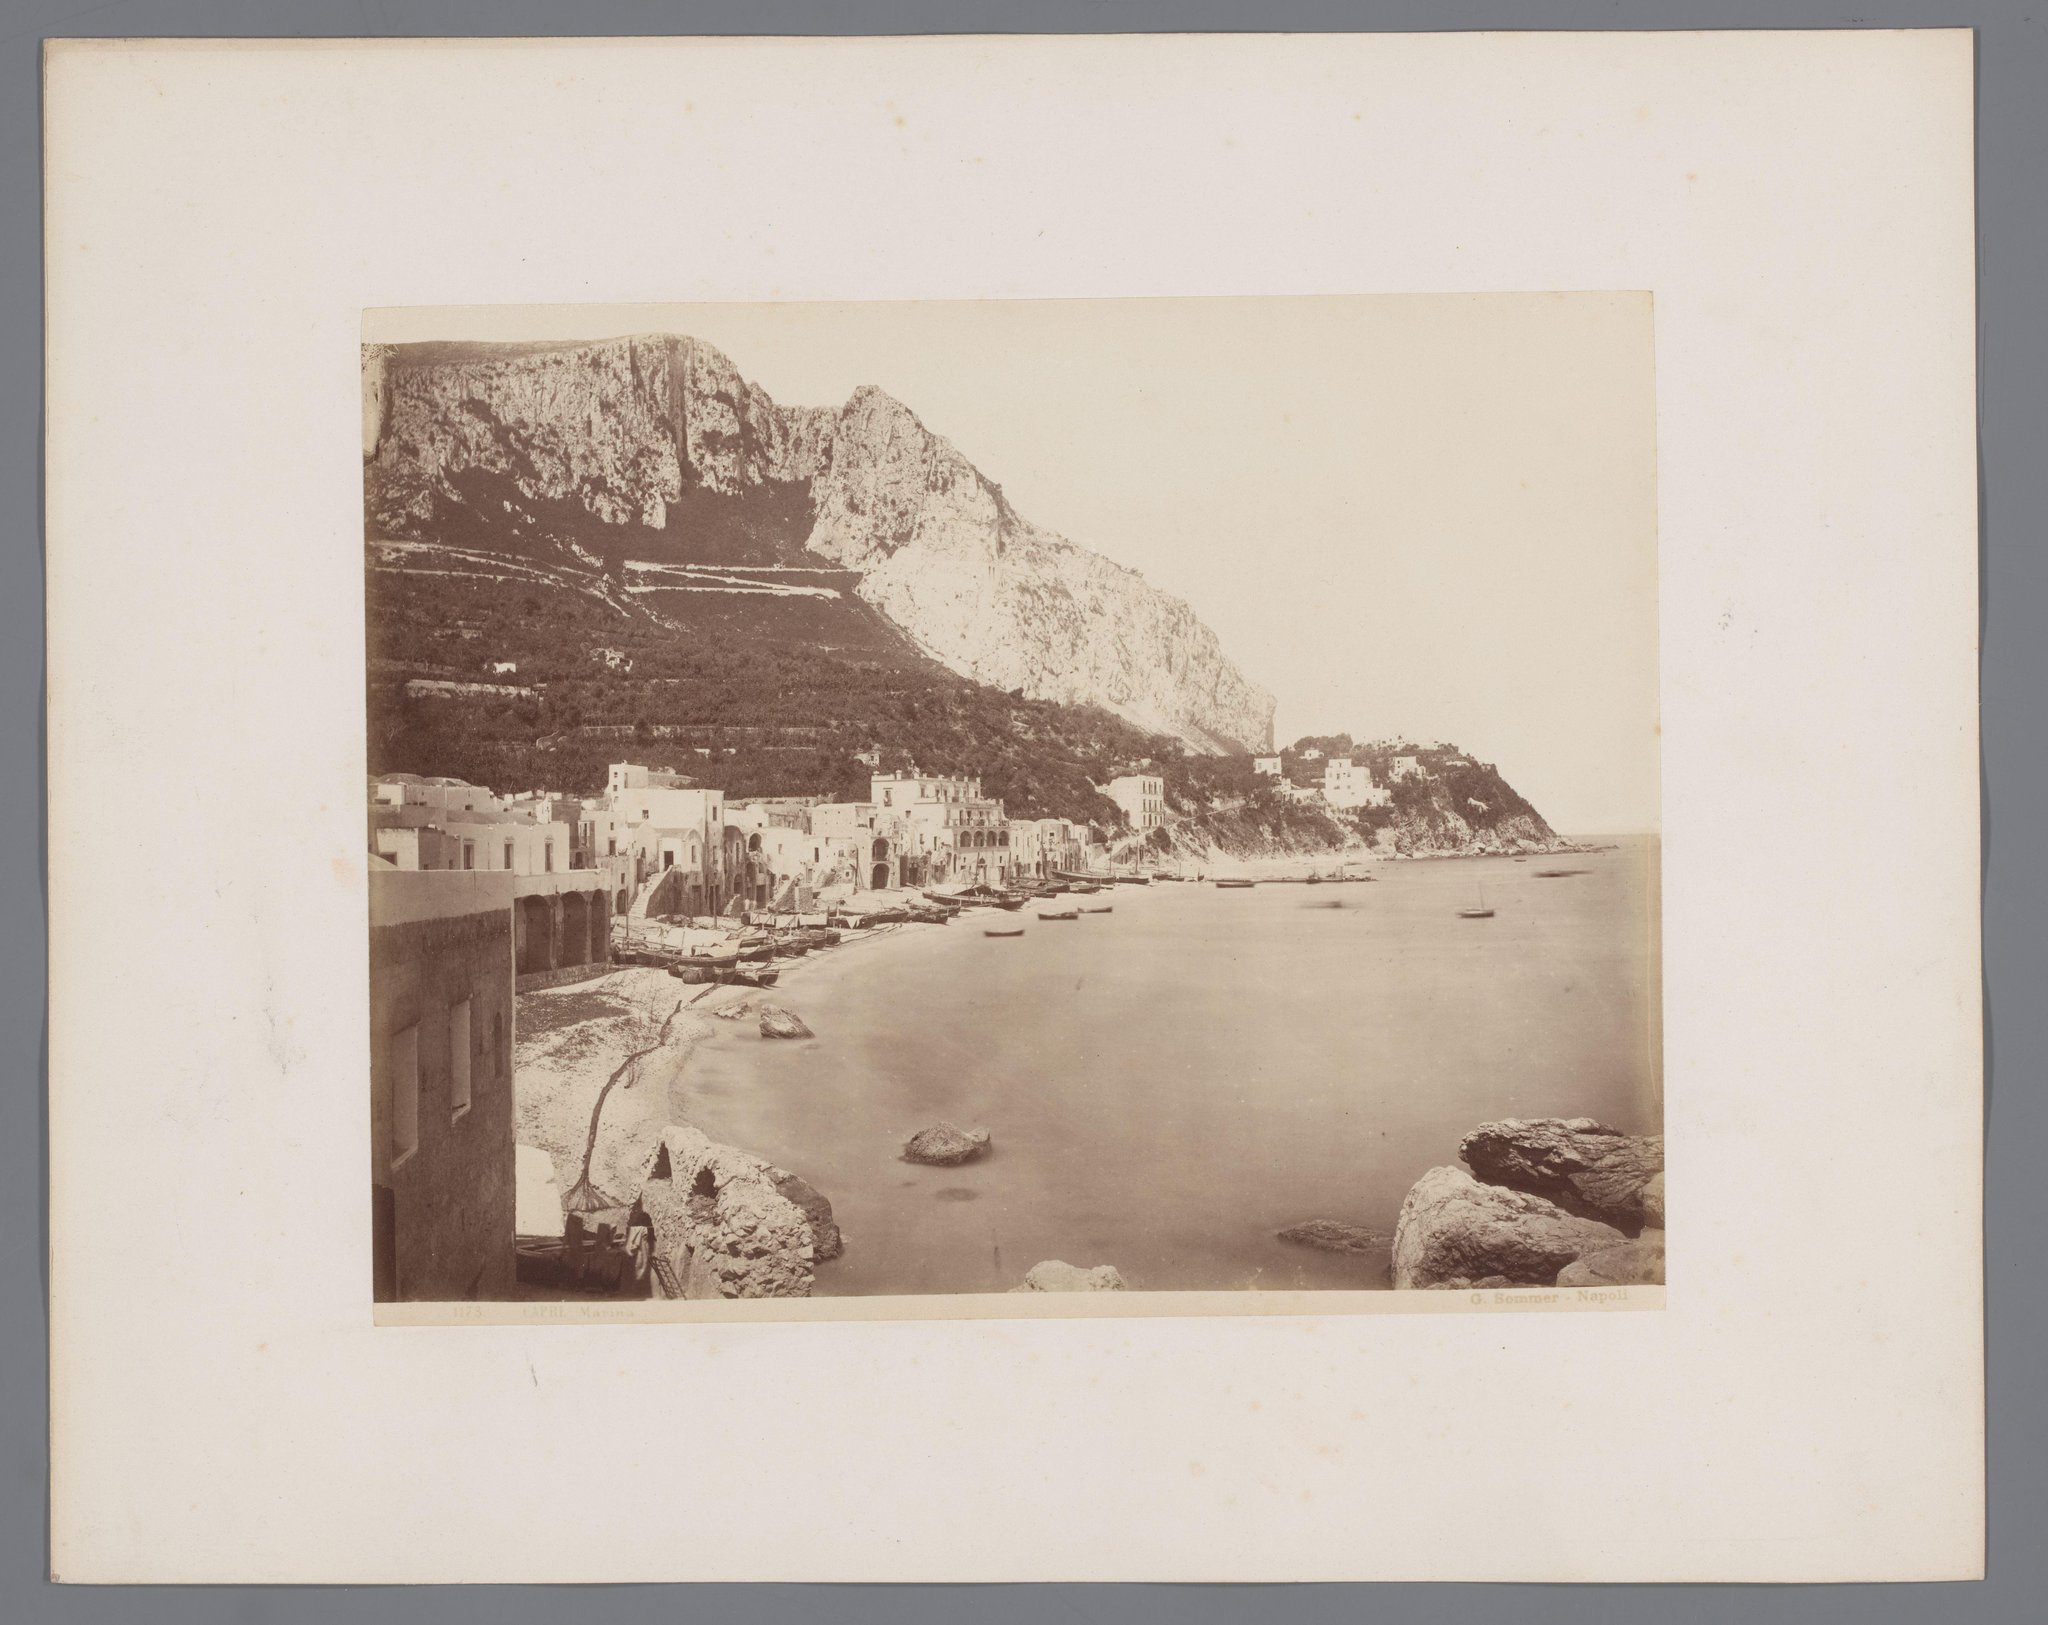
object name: photograph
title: Capri Marina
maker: giorgio sommer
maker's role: fotograaf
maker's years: 1834-1914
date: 1857-1914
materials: cardboard, paper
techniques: albumen print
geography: capri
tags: gulf, bay, capri, isola di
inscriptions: inscription: ‘Capri Marina’, number: ‘1173’